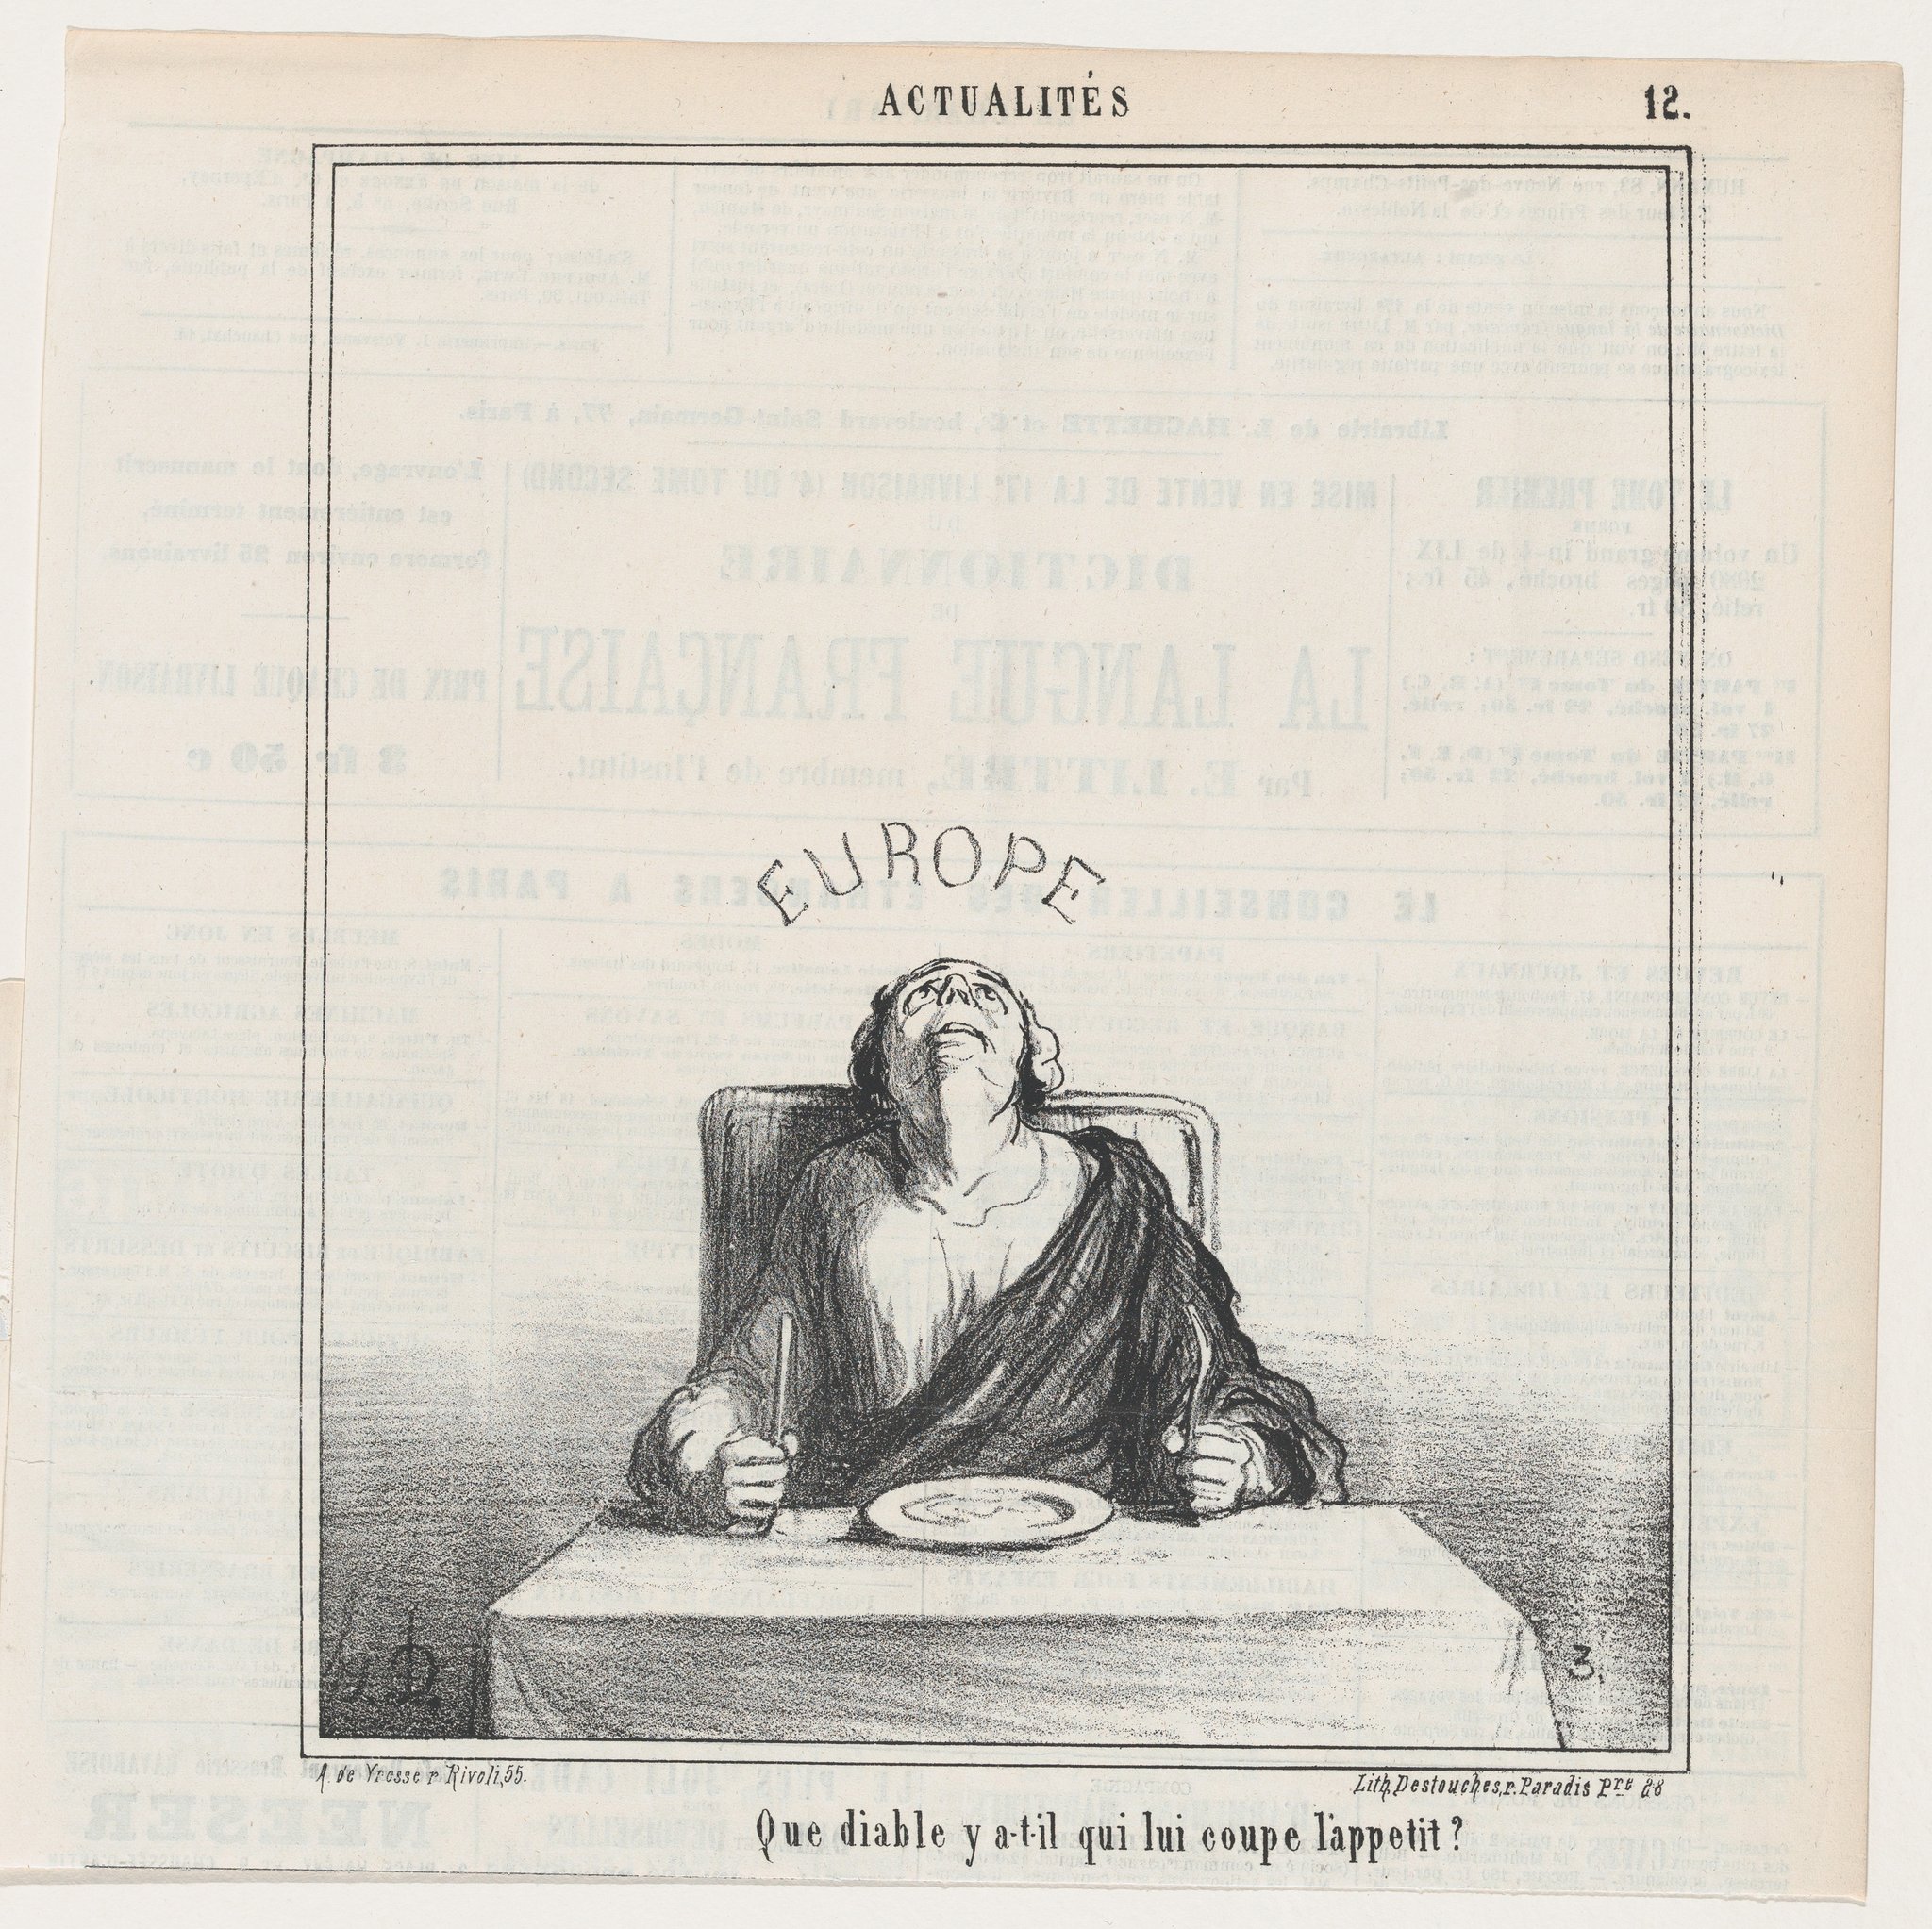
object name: print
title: What the hell can destroy her appetite?, from "News of the day"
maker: honoré daumier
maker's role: artist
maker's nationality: french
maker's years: 1808-1879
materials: paper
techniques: lithograph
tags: human figures